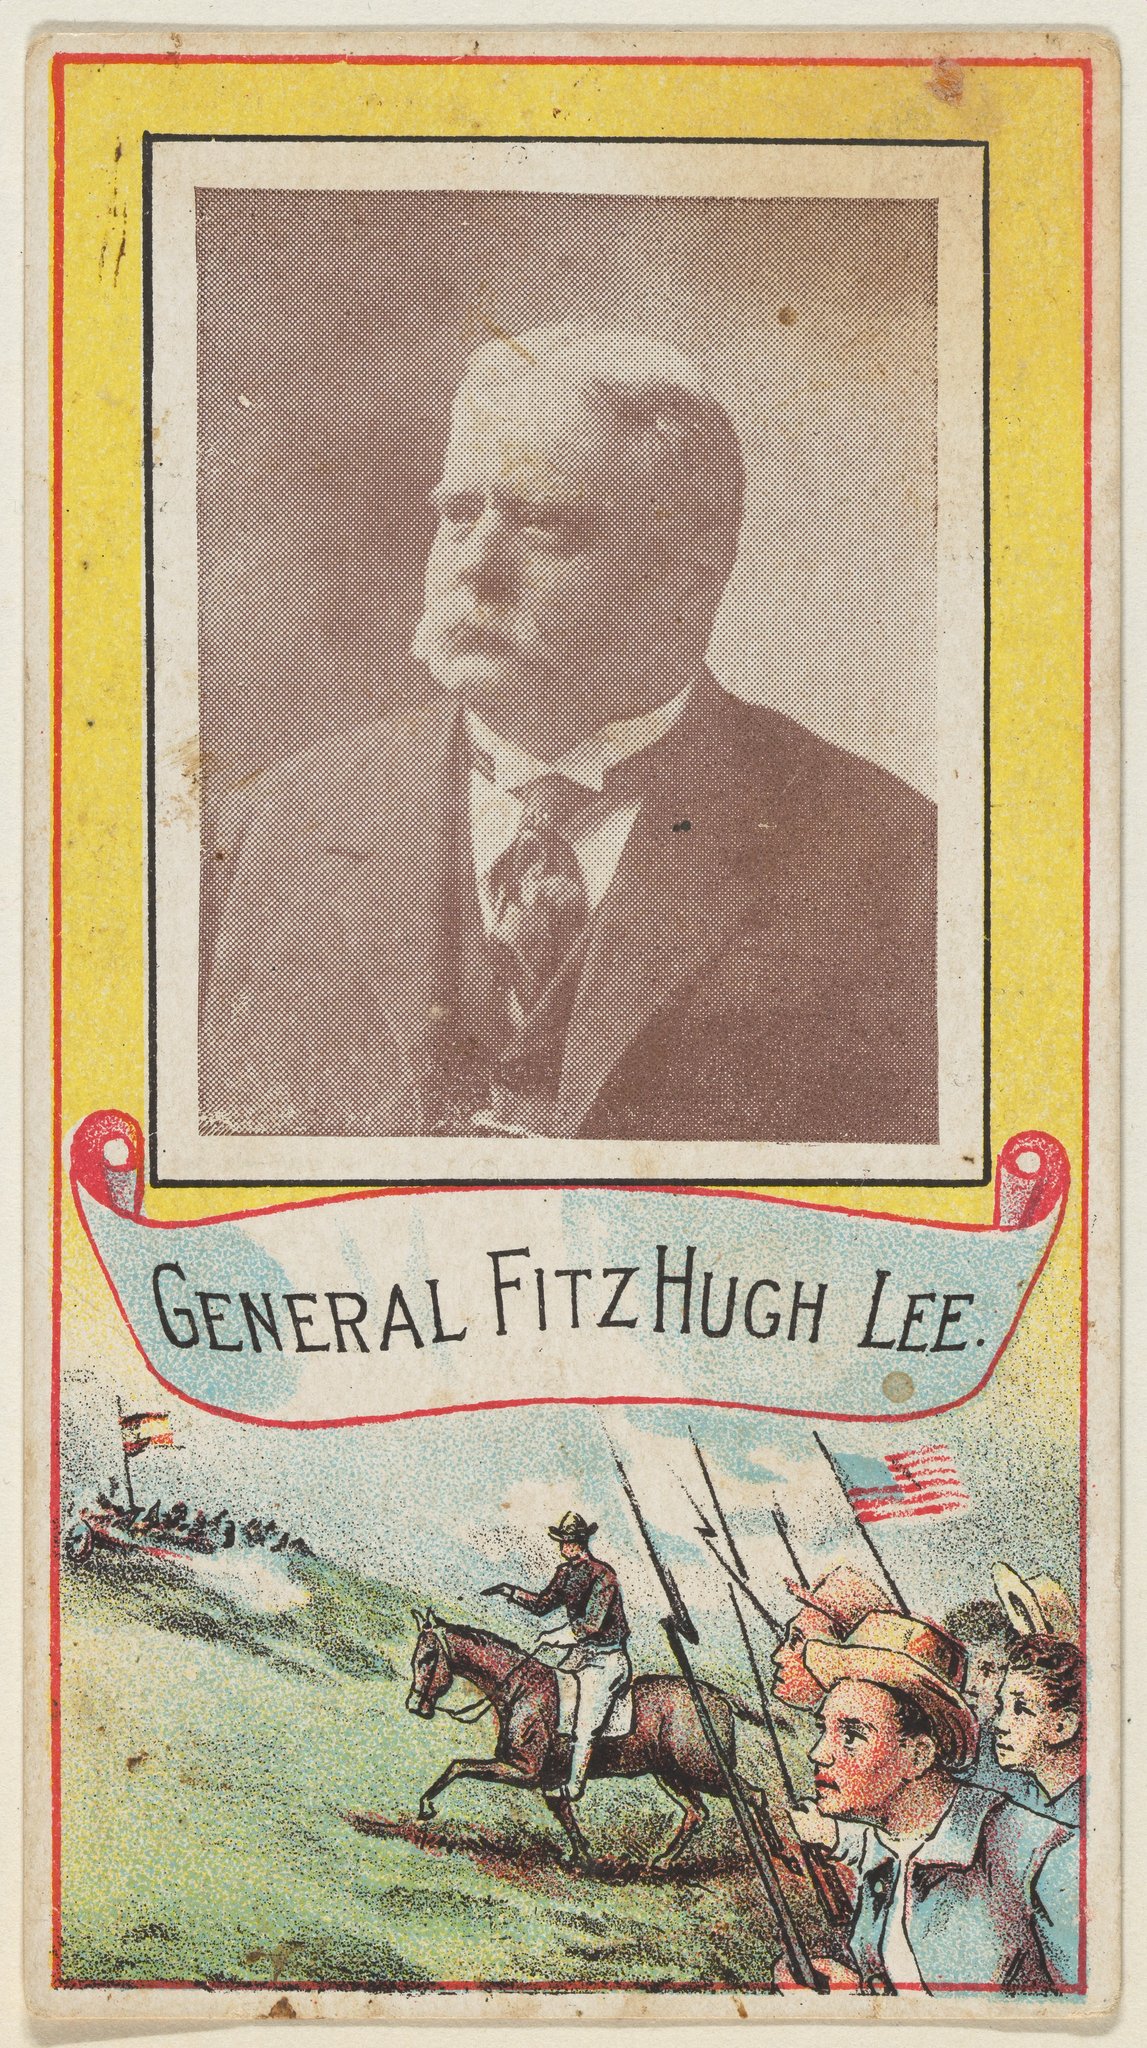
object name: print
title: General Fitzhugh Lee, from the "Generals" series (T64), issued by D.H. McAlpin & Co. Tobacco Company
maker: d.h. mcalpin & co. tobacco company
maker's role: publisher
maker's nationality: american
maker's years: 1857-1901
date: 1901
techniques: color lithograph